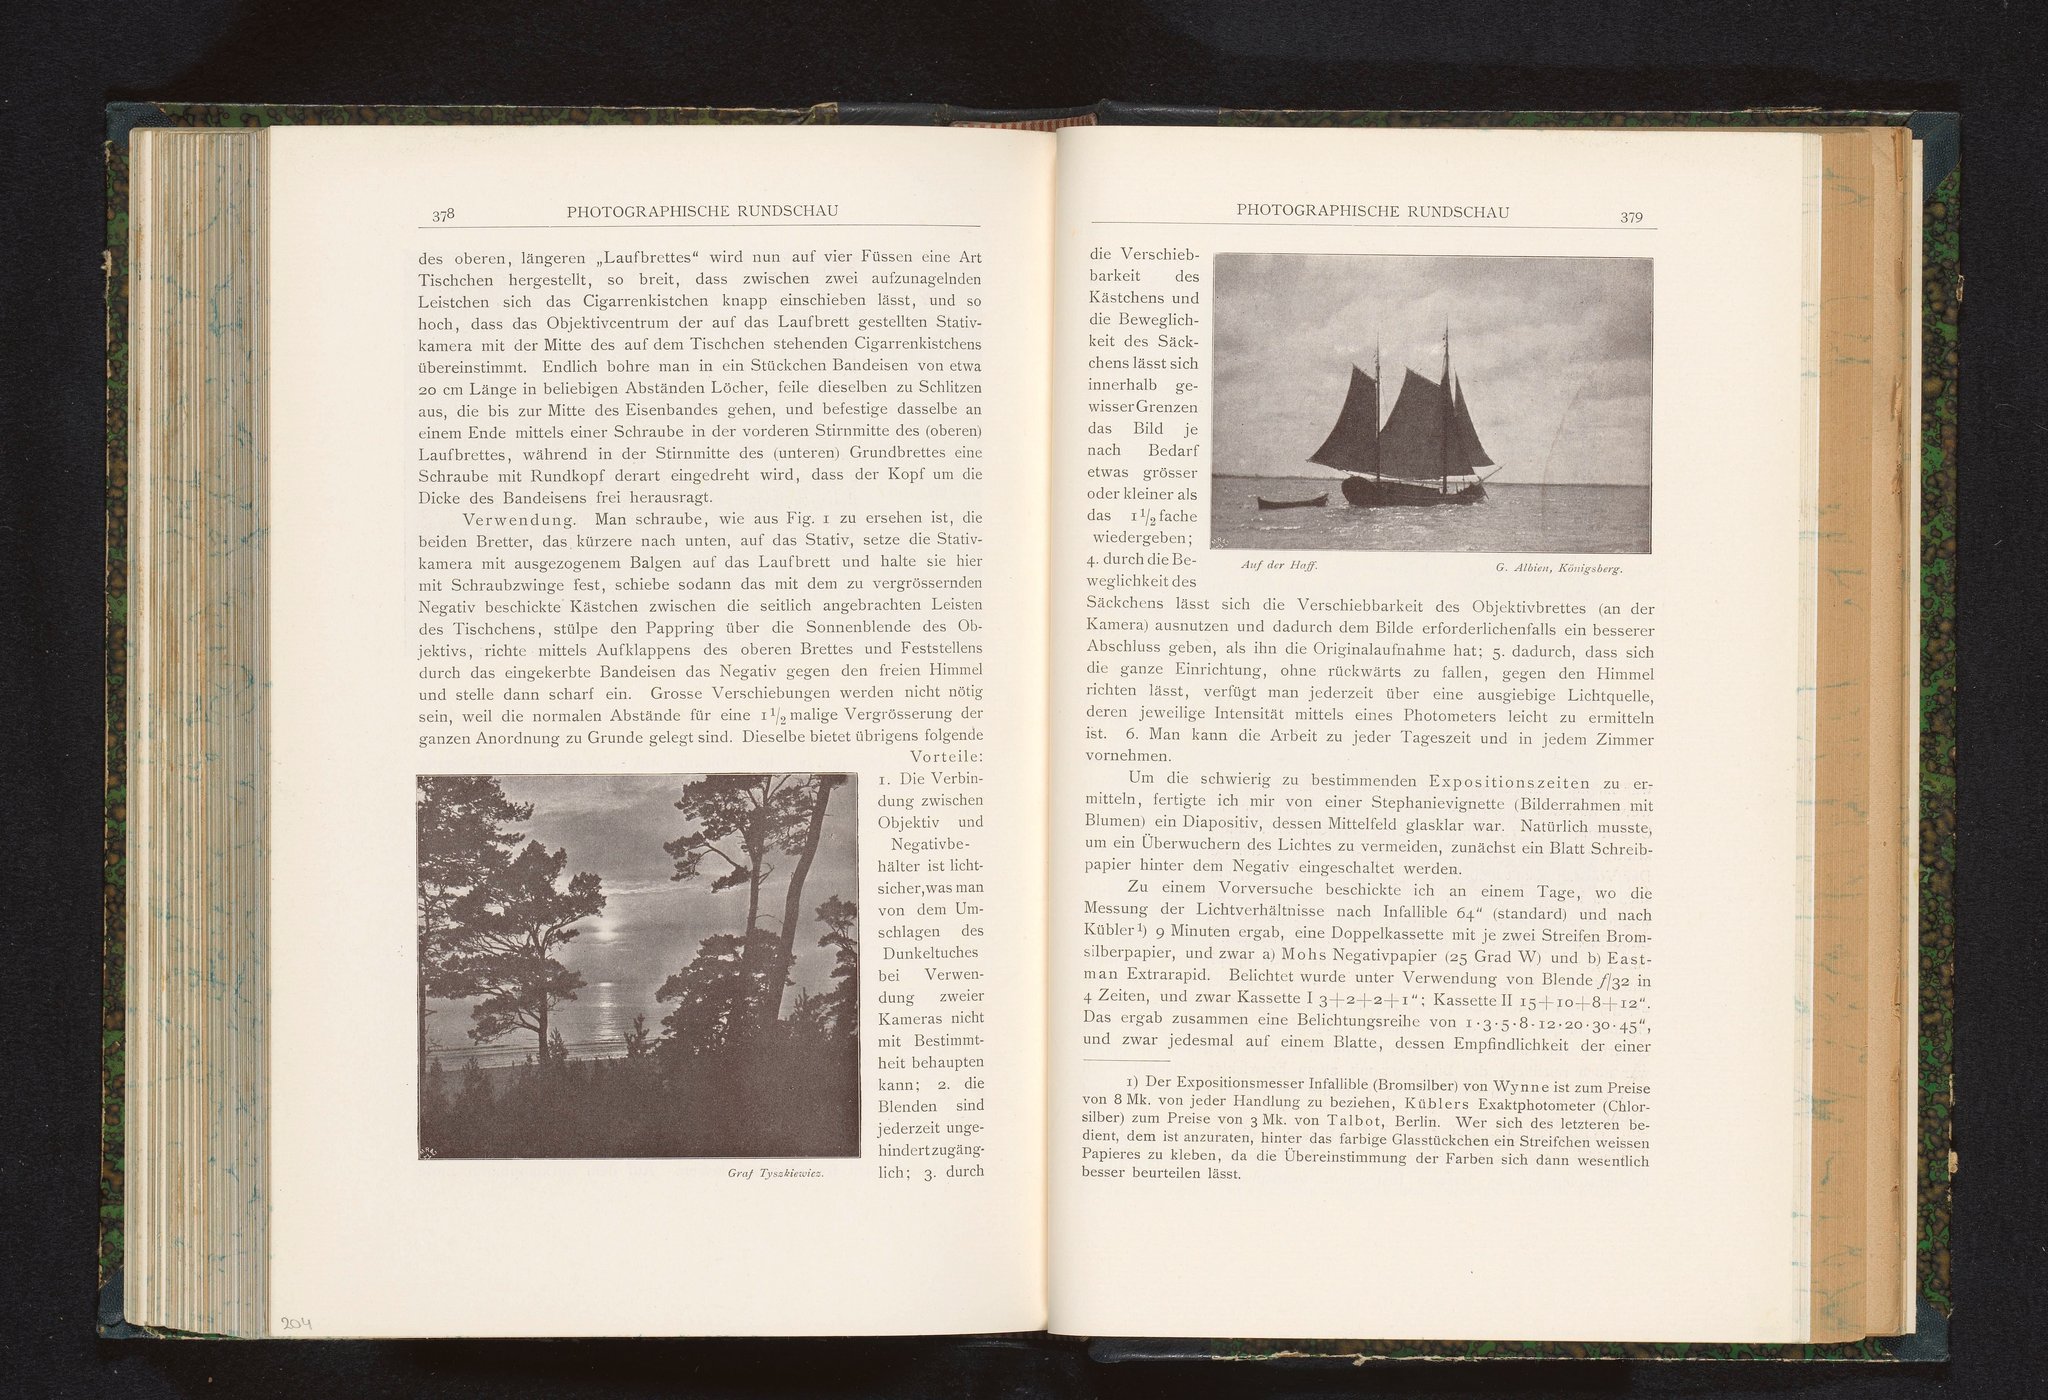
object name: page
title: Landschap bij zonsondergang met bomen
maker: benedykt henryk tyszkiewicz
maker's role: fotograaf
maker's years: 1852-1935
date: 1894-1899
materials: paper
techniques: autotype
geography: berlin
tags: trees, landscapes